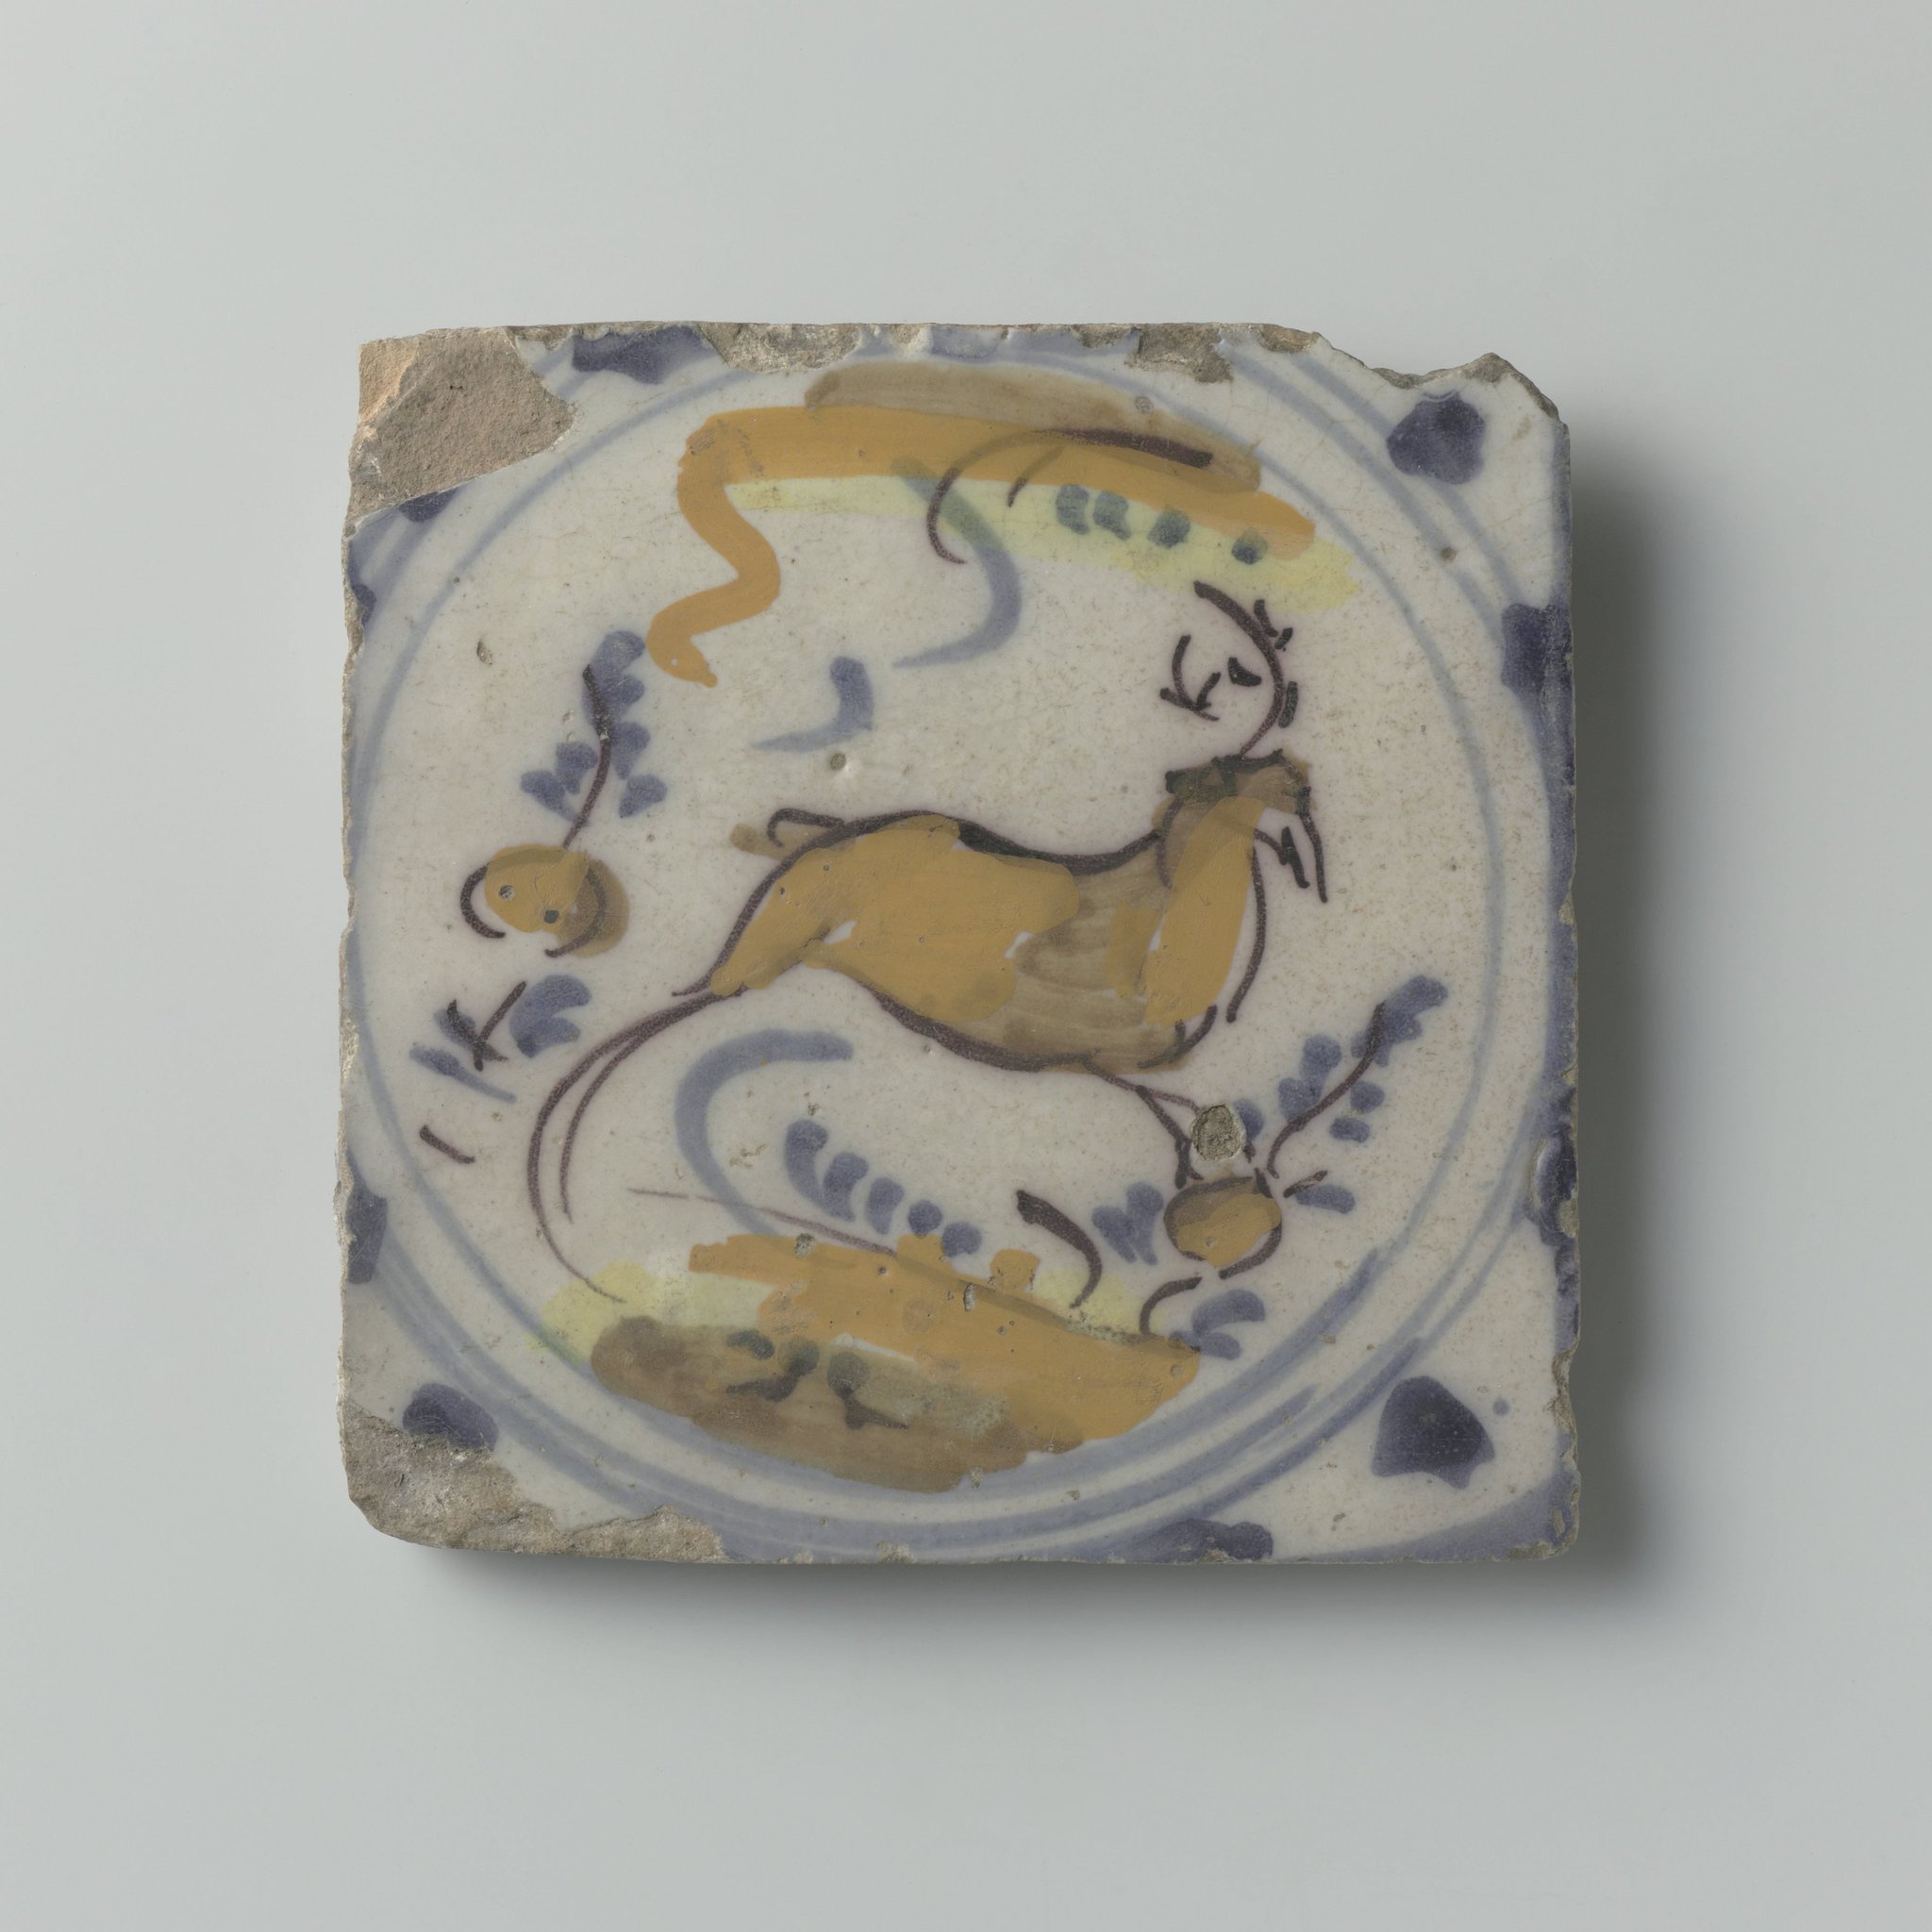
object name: tile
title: Tegel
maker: Anonymous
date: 1700-1800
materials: earthenware, glaze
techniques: maiolica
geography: talavera de la reina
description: Majolica-tegel, beschilderd in geel, mangaan en blauw. In een cirkel een naar rechts springend hert.